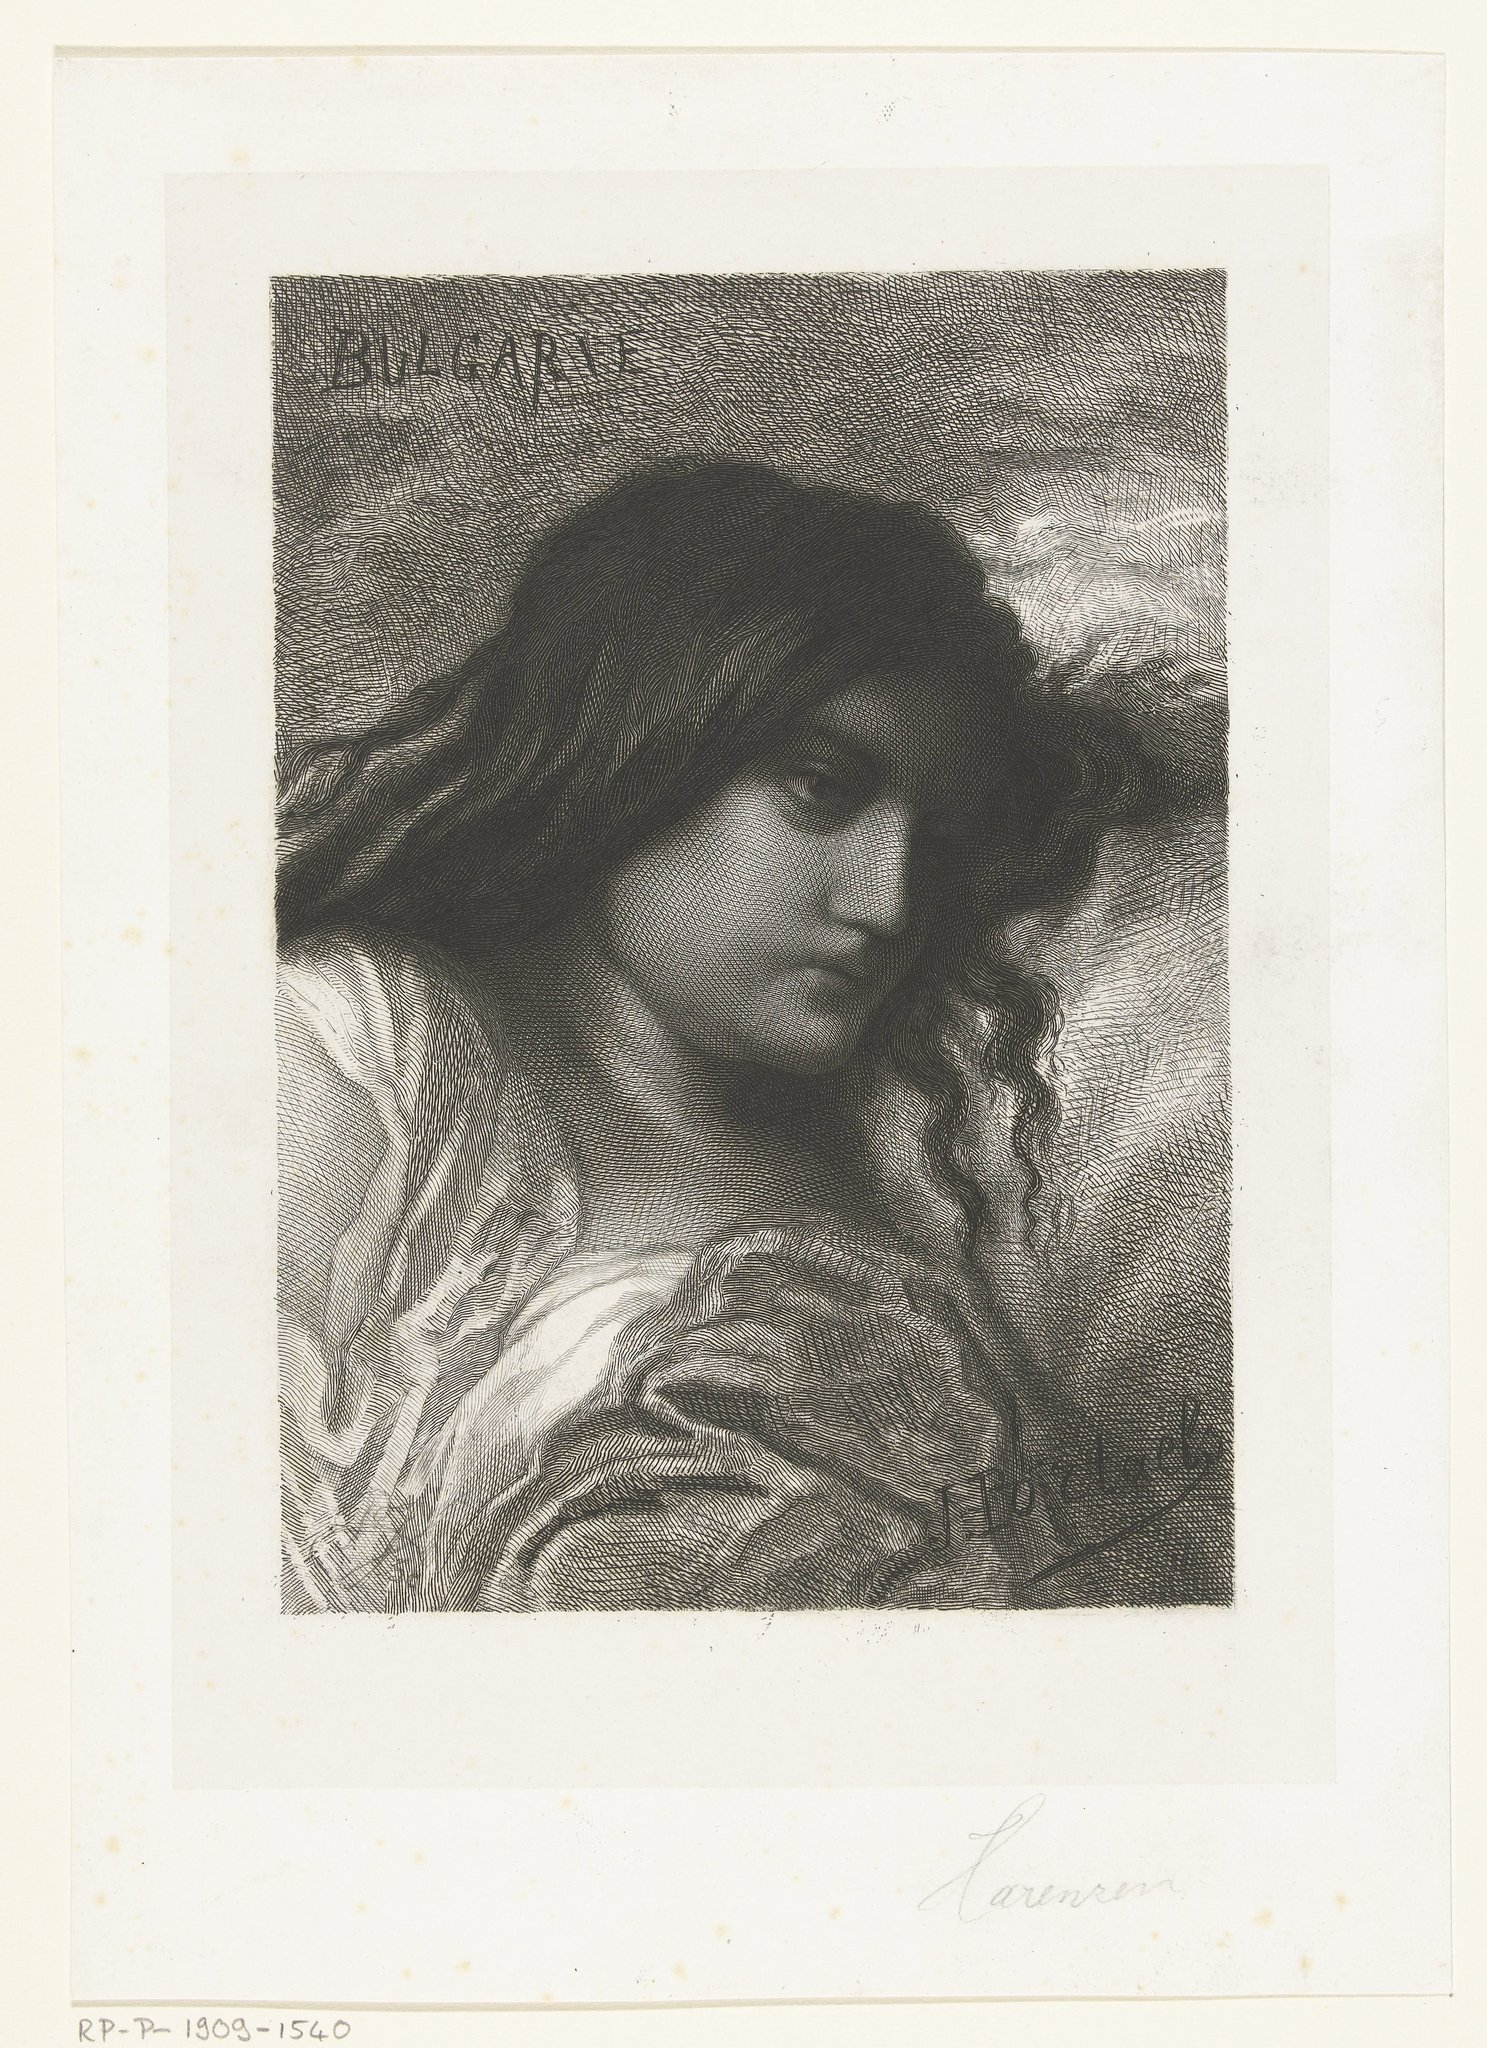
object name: print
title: Portret van een jonge vrouw met lang donker haar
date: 1856-1909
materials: paper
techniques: engraving, etching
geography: netherlands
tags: human races; peoples; nationalities (+ women)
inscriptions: collector's mark: Lugt 2228